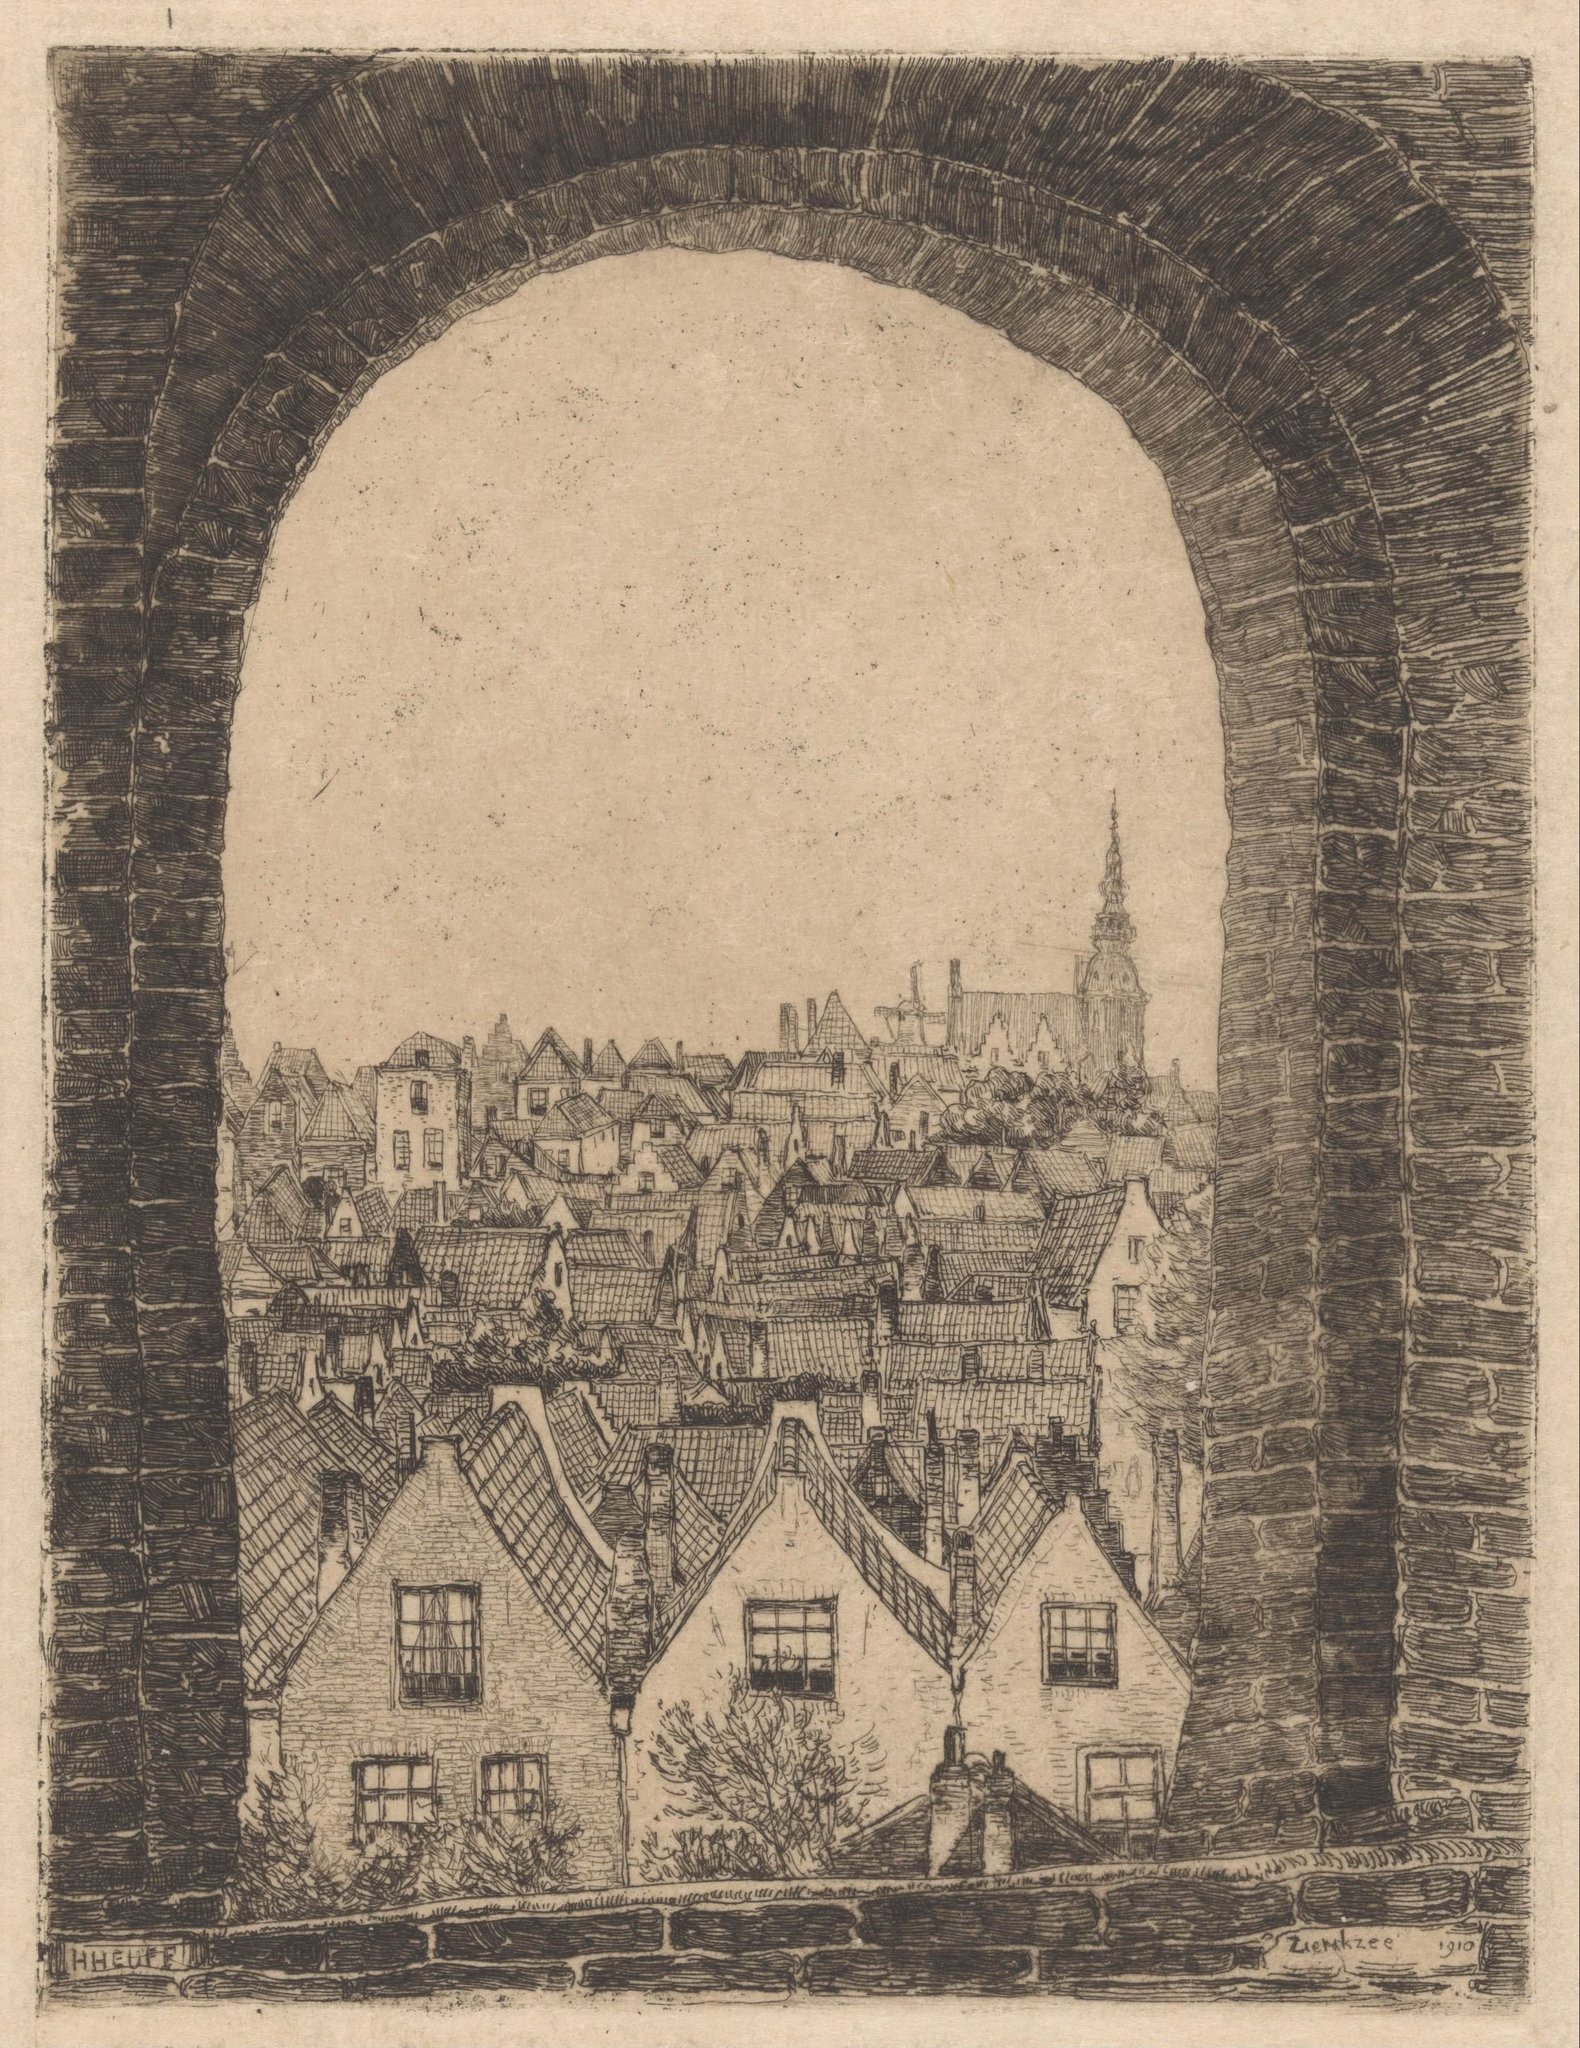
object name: print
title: Gezicht op Zierikzee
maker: herman heuff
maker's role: print maker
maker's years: 1875-1945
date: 1910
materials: paper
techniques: etching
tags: city-view in general; 'veduta', townhall, windmill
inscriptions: collector's mark: Lugt 2760, collector's mark: Lugt 2228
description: Zierikzee gezien door een stenen poort. Rechts op de achtergrond een molen en het stadhuis.